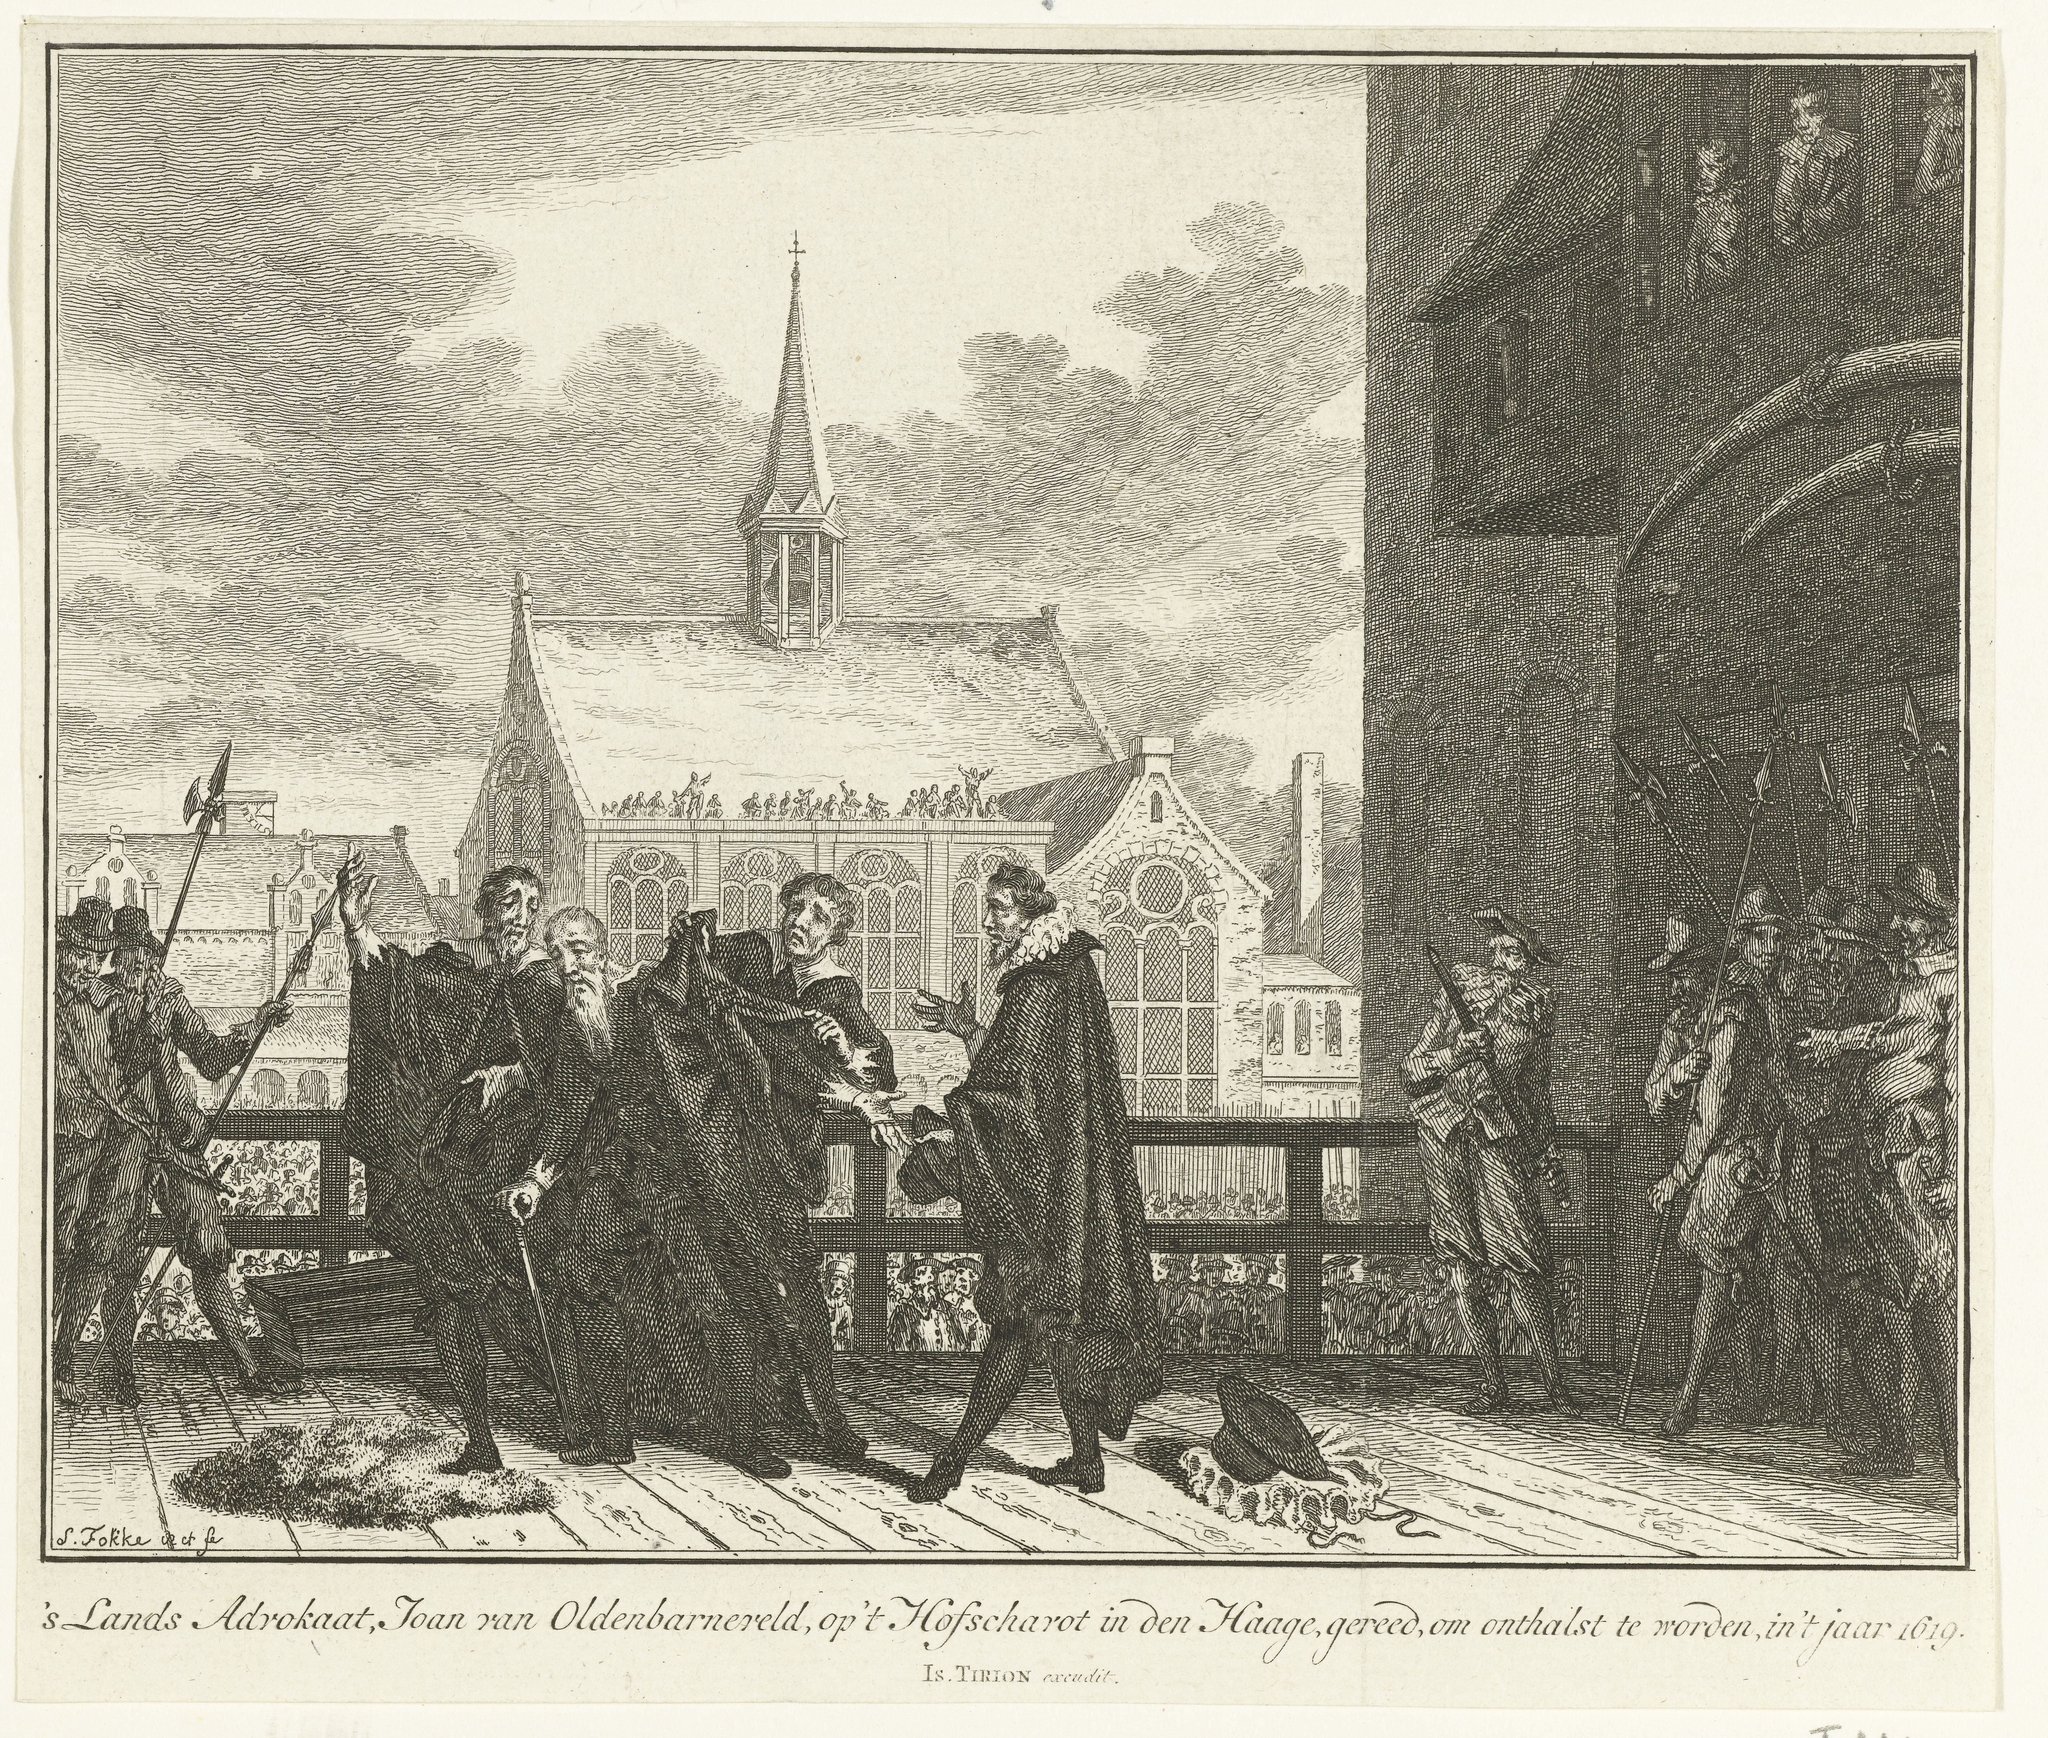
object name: history print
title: Johan van Oldenbarnevelt op het schavot, 1619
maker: simon fokke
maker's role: draughtsman, print maker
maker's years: 1712-1784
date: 1747-1759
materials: paper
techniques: etching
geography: northern netherlands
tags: the hague, johan van oldenbarnevelt, maurice (prince of orange), on the scaffold or place of execution, violent death by beheading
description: Gebruikt als illustratie in: Jan Wagenaar, Vaderlandsche historie, I. Tirion, Amsterdam 1749-1759, 21 delen. De onder de nummers FMH 1394a en 1394b door Muller beschreven platen zijn niet verschillende staten van dezelfde plaat, maar twee verschillende platen.